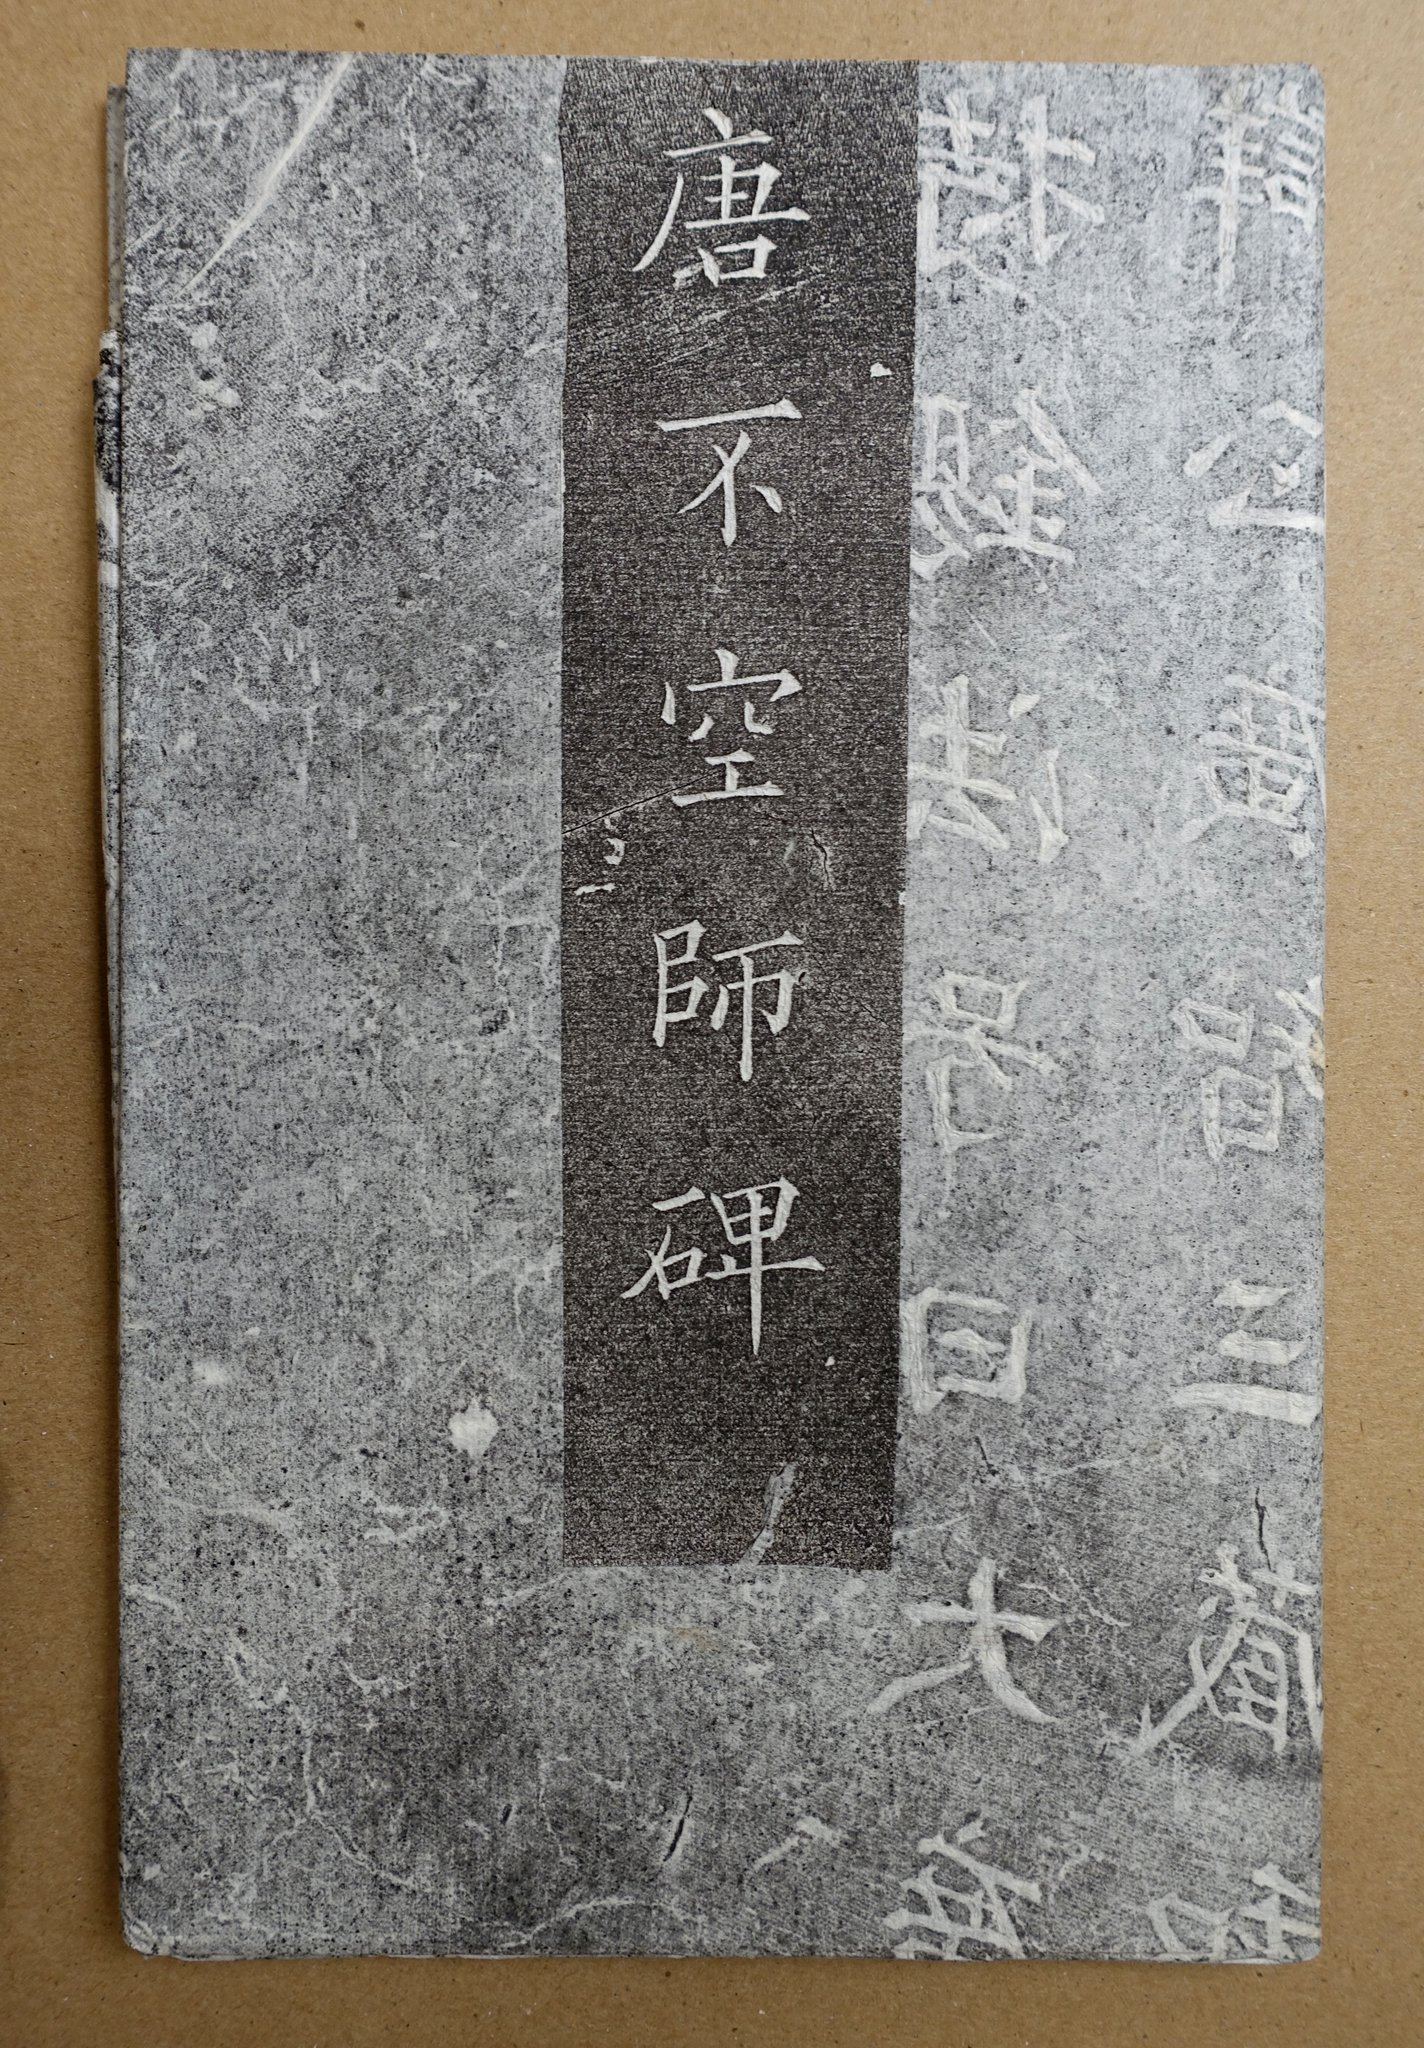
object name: rubbing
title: Epitaph for the Indian Monk Amogavajra (705-774)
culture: chinese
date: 1901-2000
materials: ink, paper